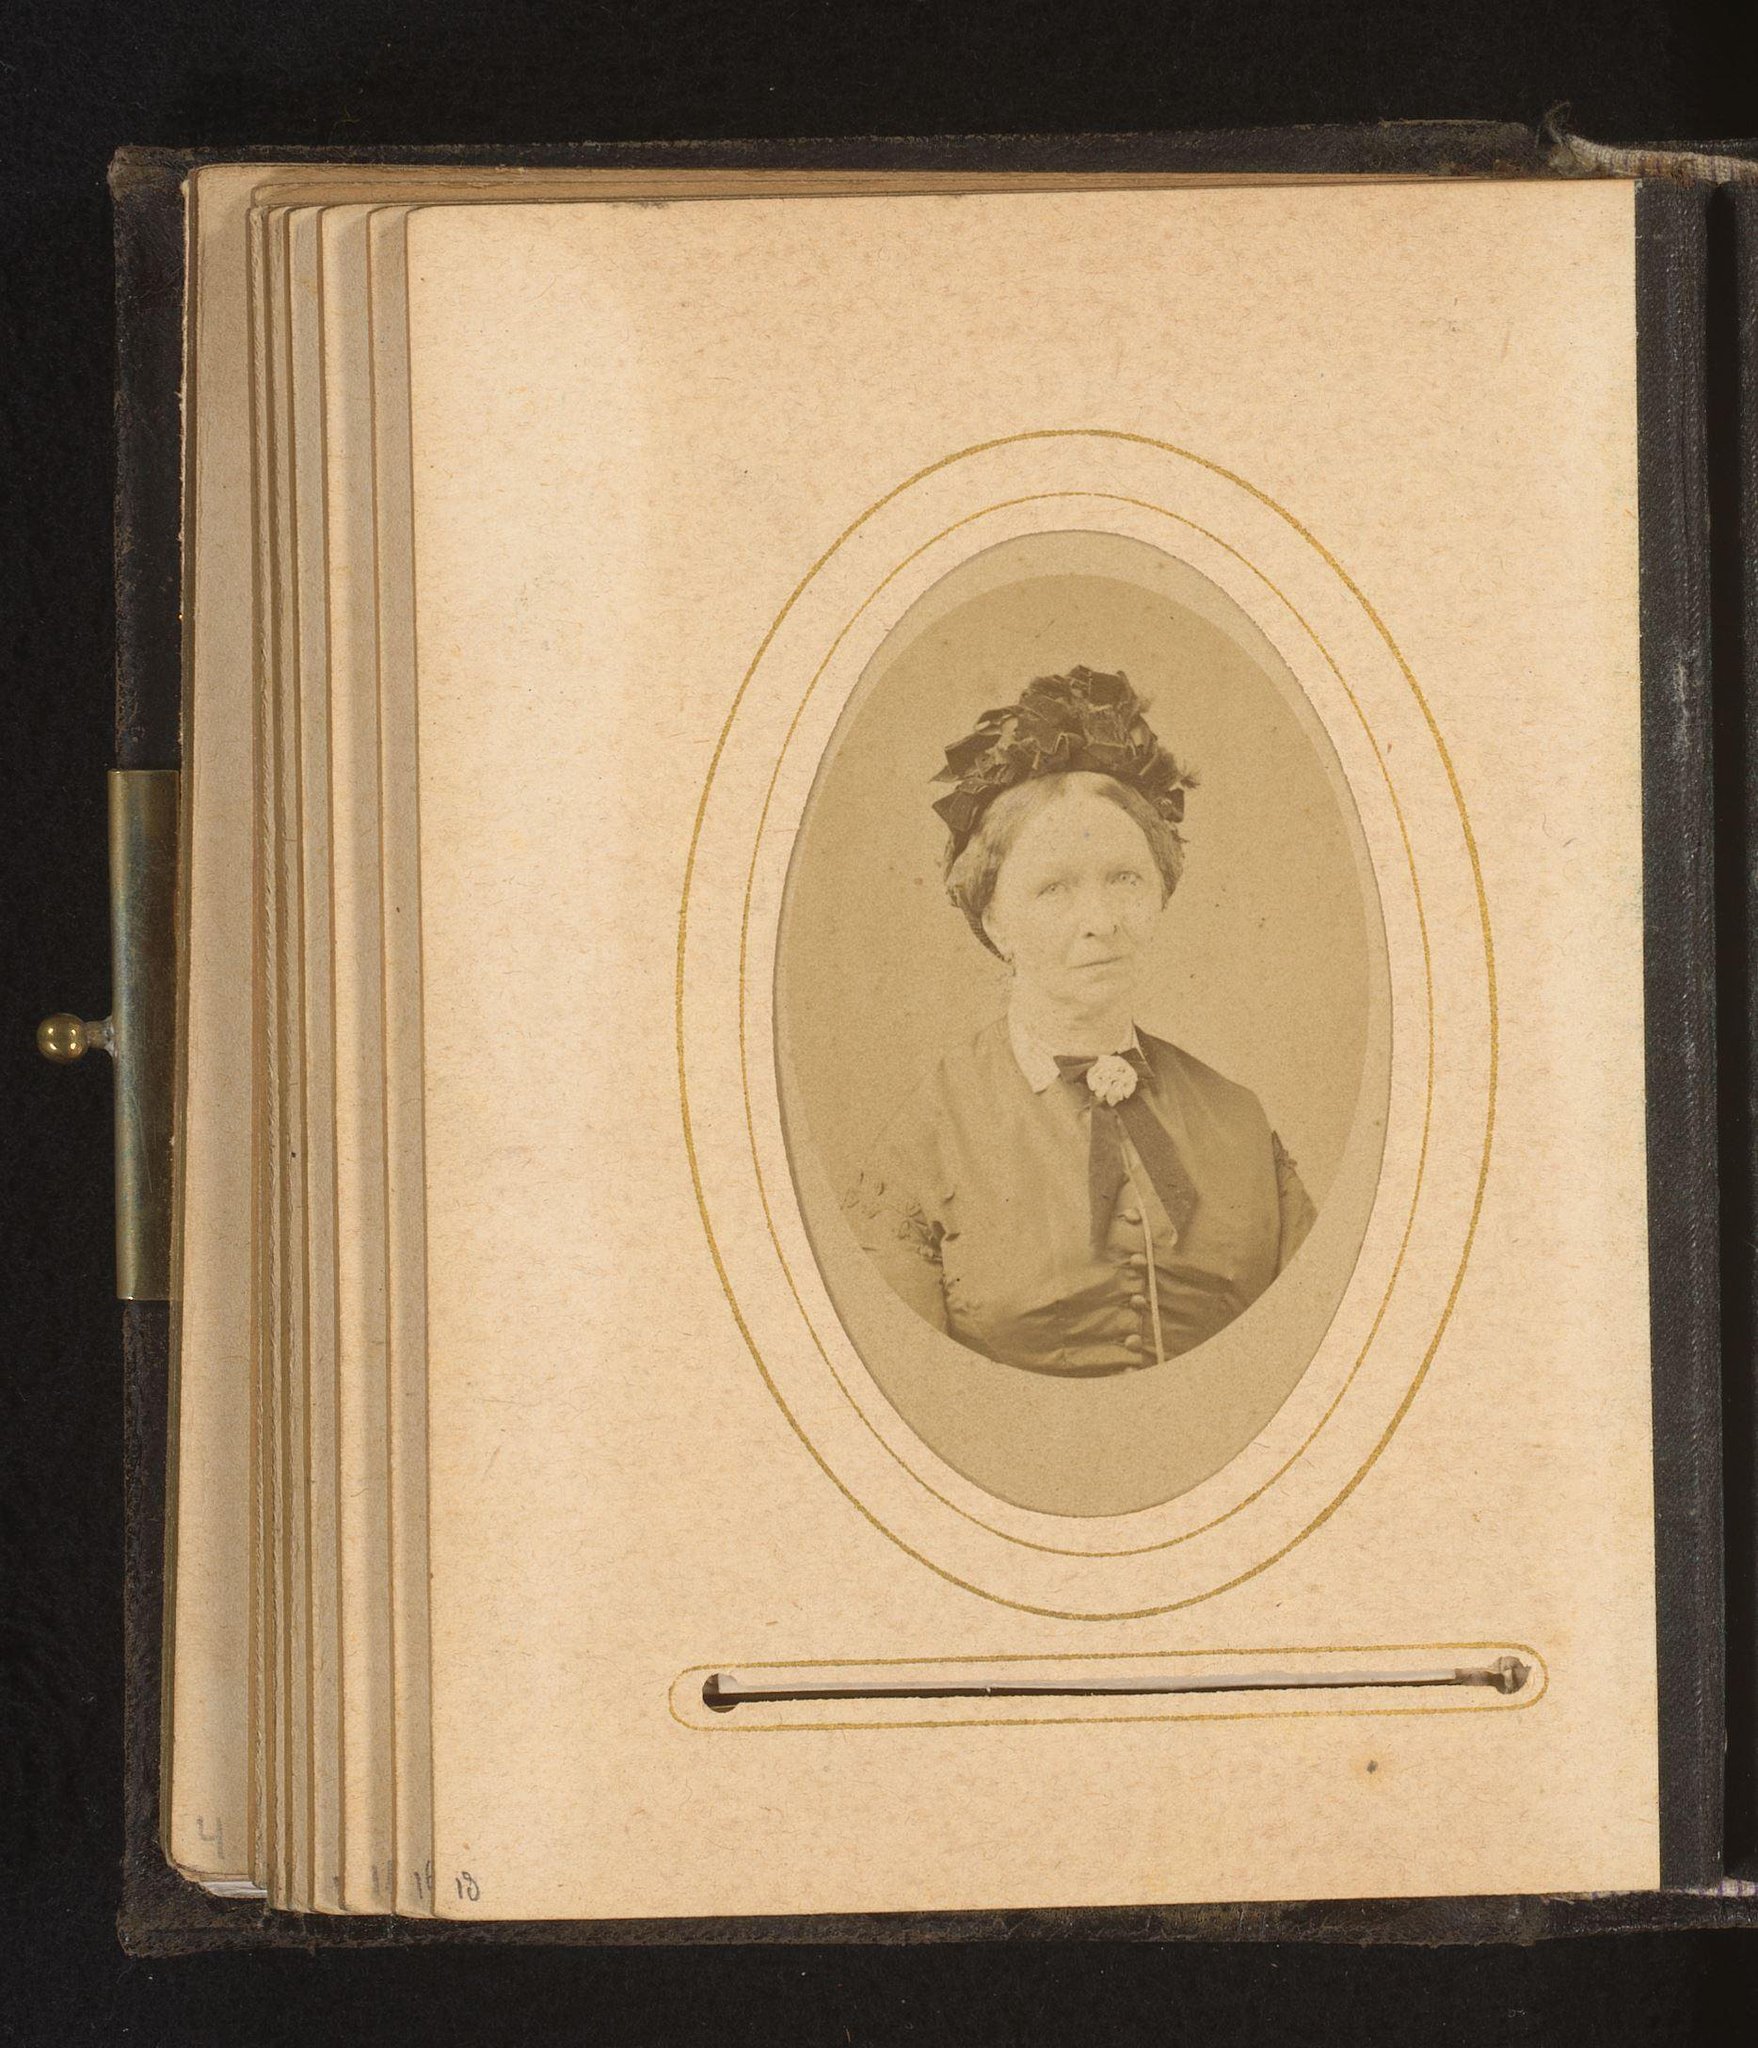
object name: carte de visite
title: Portret van een oude vrouw met muts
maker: jan george mulder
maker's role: fotograaf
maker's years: 1816-1895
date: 1865-1887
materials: cardboard, photographic support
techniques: albumen print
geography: haarlem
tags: old woman, head-gear: cap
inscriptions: inscription: ‘Photogr. Atelier/ J.G. Mulder/ Lange Bagijnestraat/ Haarlem’